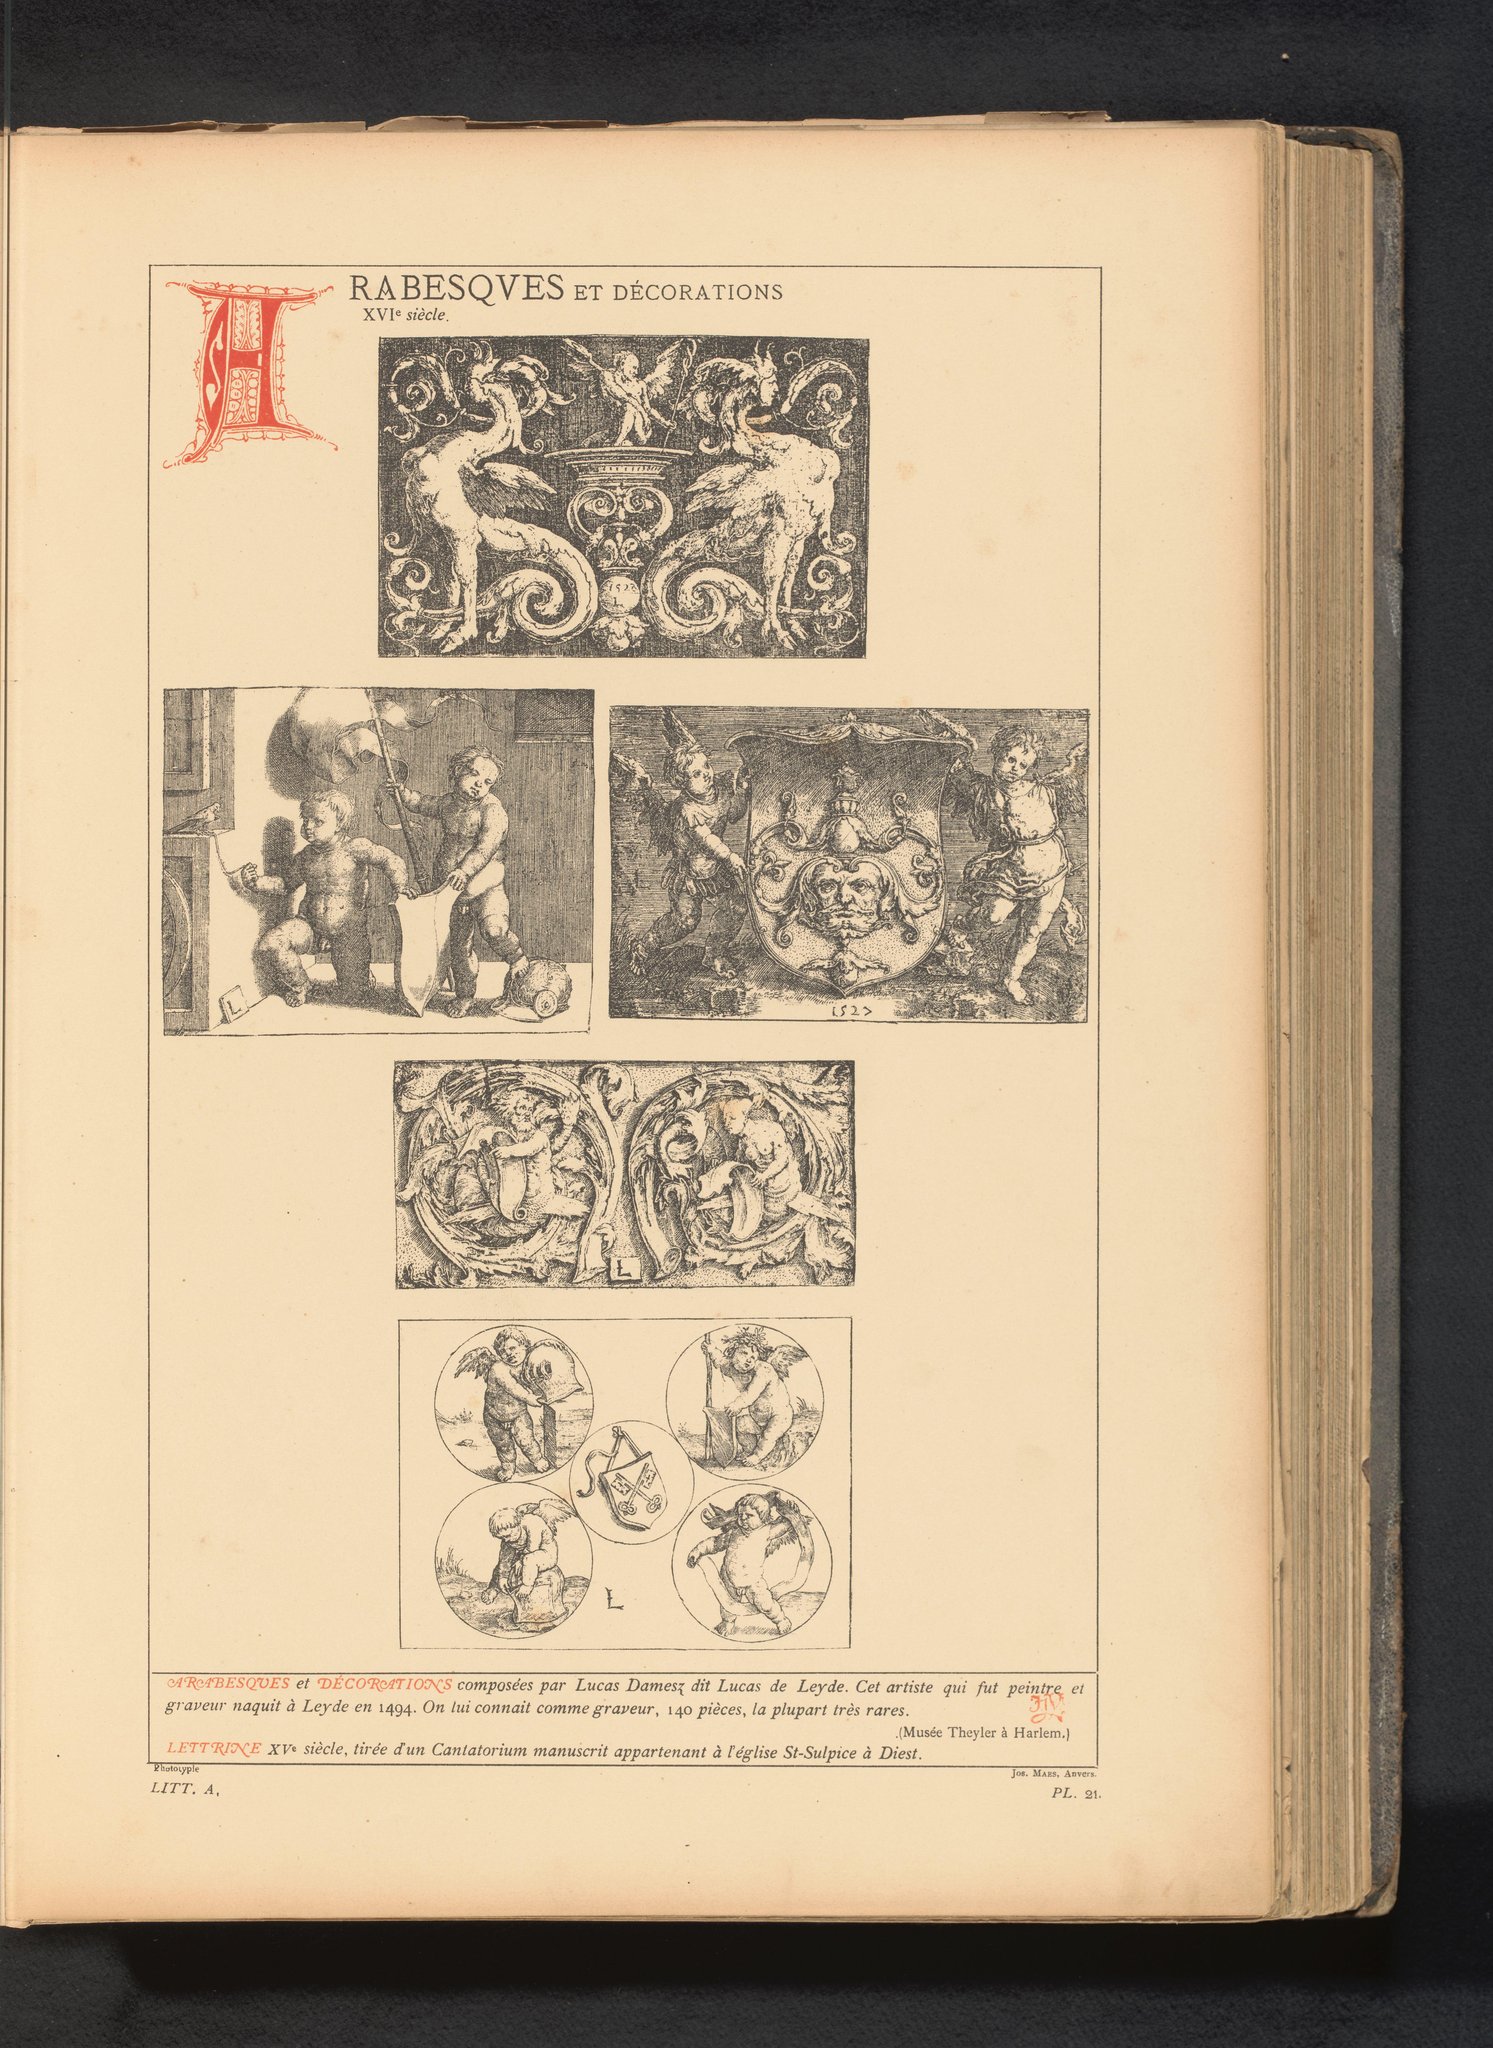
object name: photomechanical print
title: Arabesques et décorations, XVIe Siècle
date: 1875-1880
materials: paper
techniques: photolithography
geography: antwerp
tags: decorations (interior of the house)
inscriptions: inscription: ‘LITT: A. - PL. 21’, monogram: ‘JJvY’, inscription: ‘Arabesques et décorations (...)’